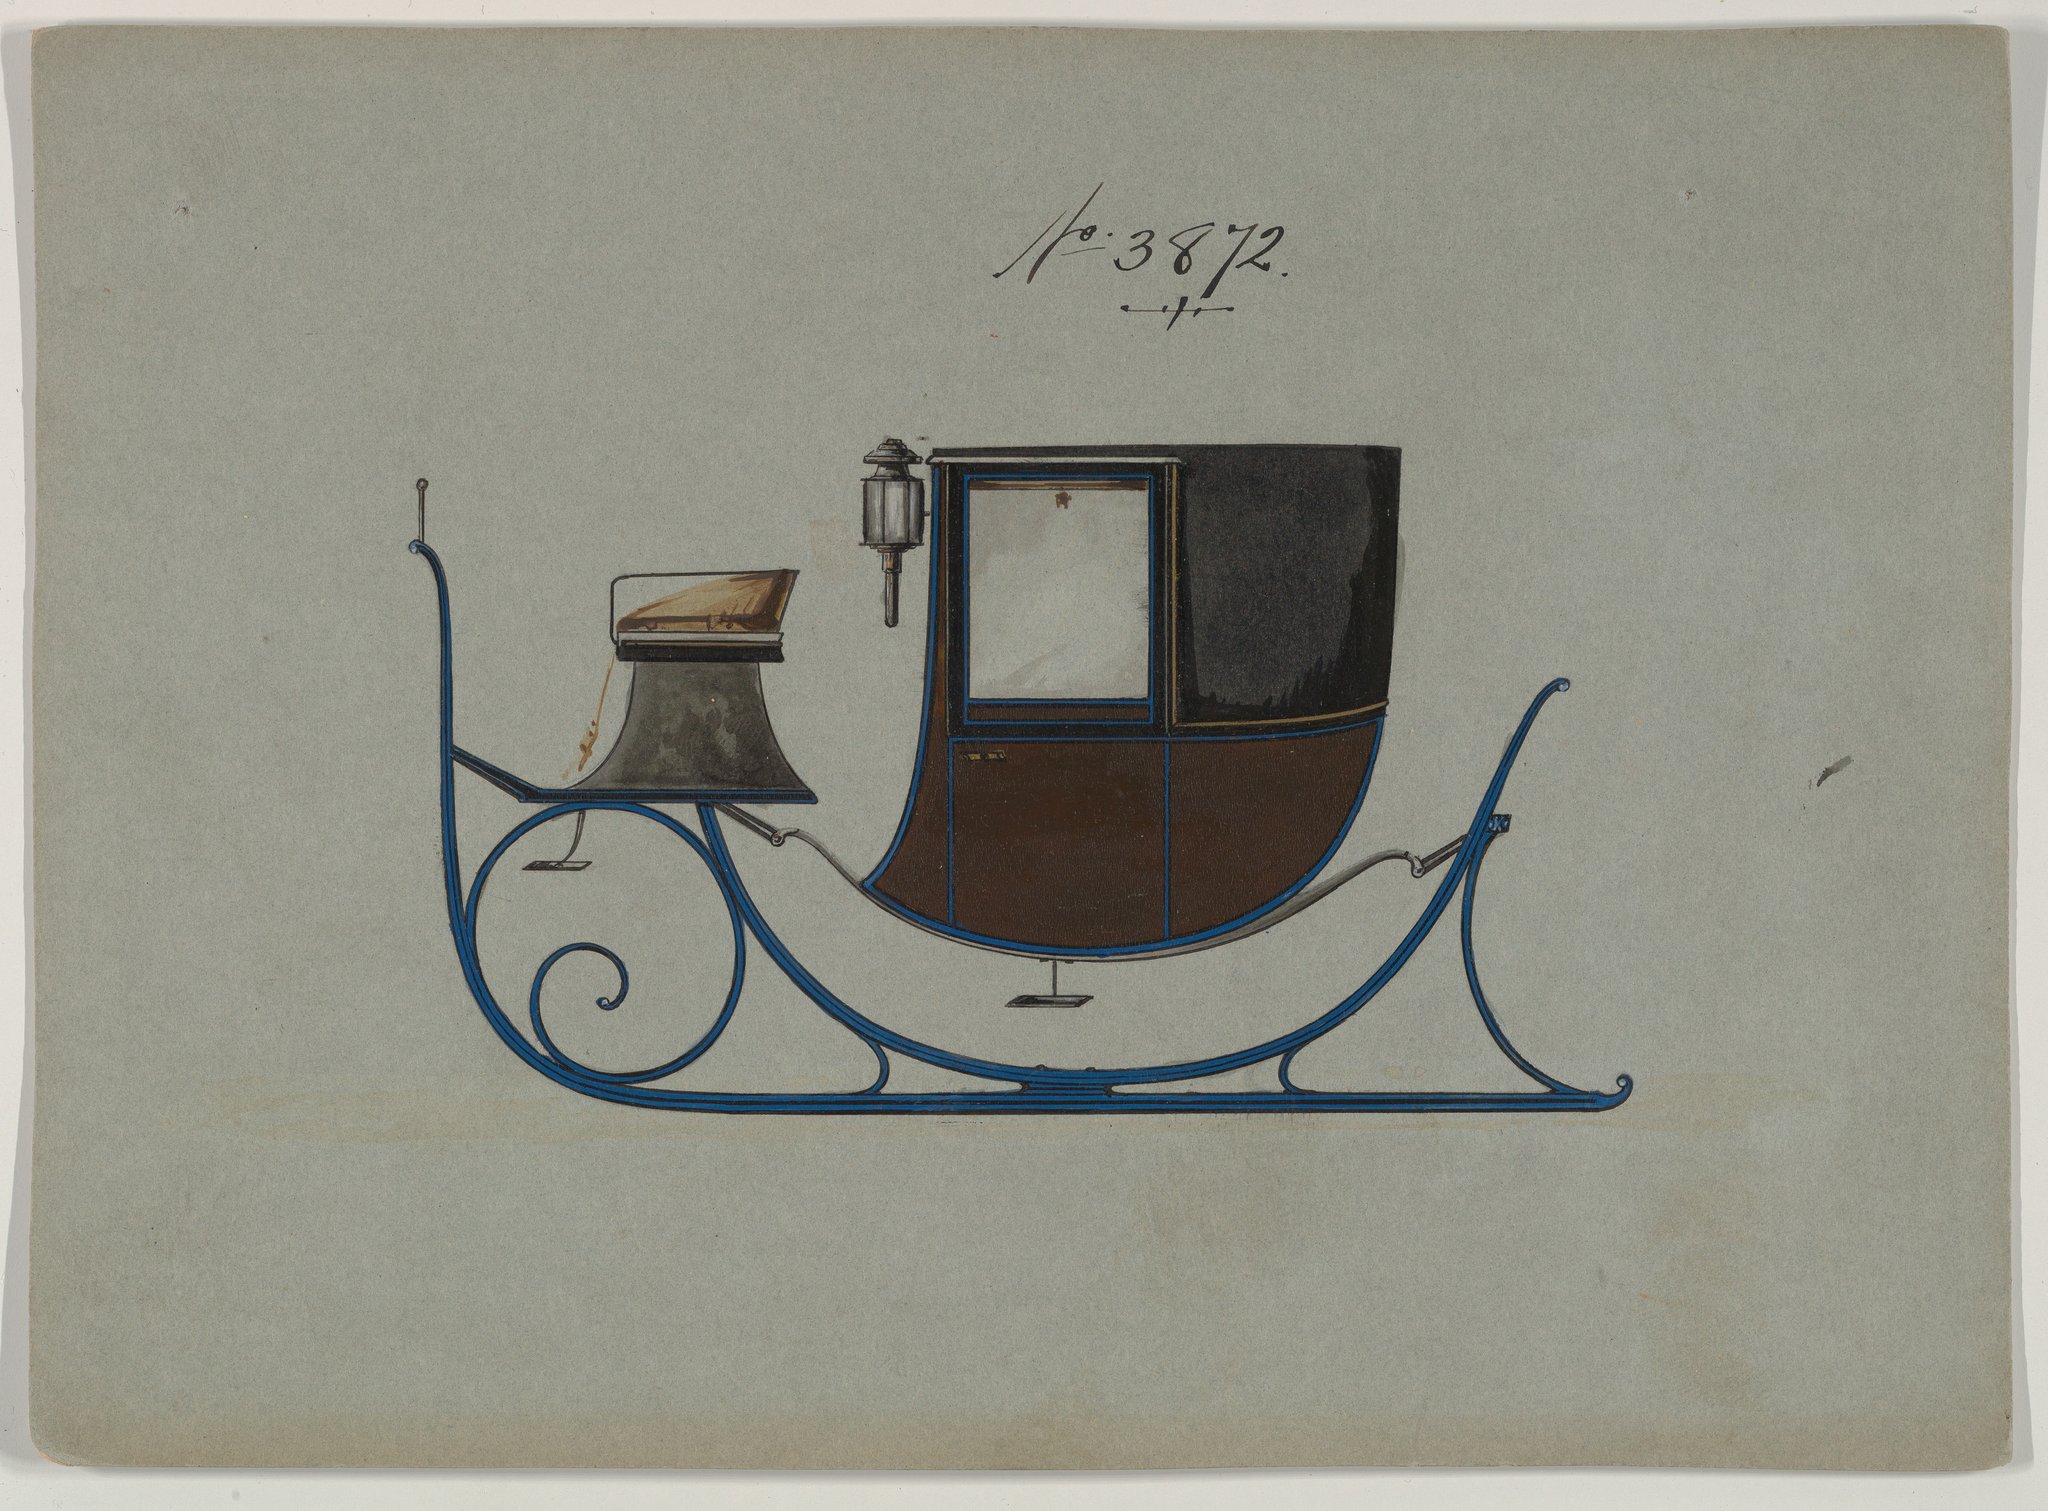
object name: drawing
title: Design for a Booby Hut Chariot Body Sleigh, no. 3872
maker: brewster & co.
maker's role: manufacturer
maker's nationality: american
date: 1884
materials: gouache, gum arabic, ink, watercolor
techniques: pen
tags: sleighs